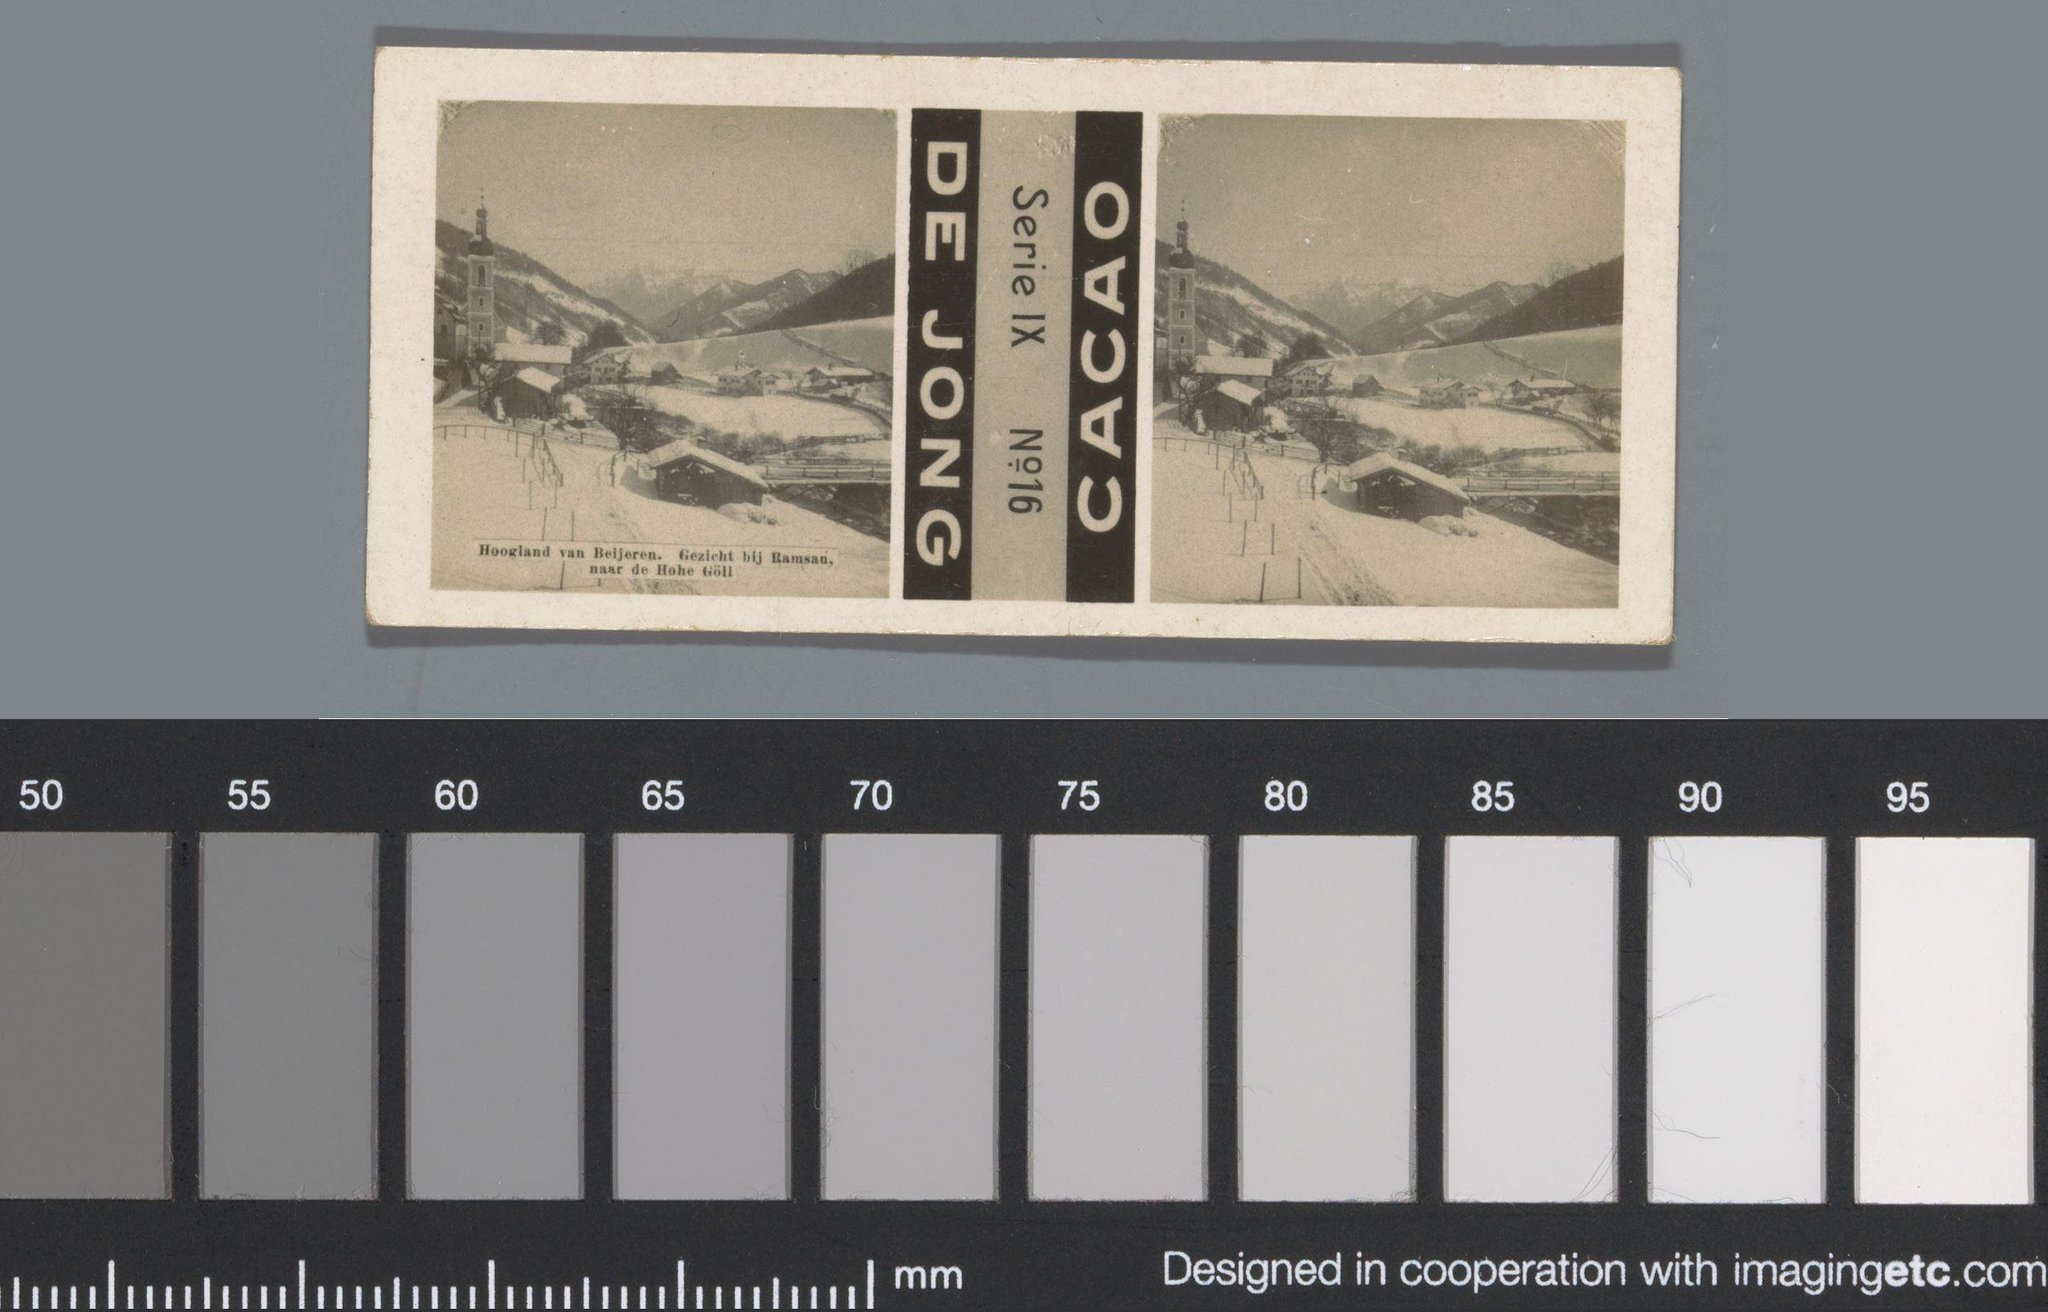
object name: stereograph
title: Gezicht op Ramsau bei Berchtesgaden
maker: Anonymous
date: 1900-1910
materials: cardboard, photographic support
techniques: gelatin silver print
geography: wormerveer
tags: city-view in general; 'veduta', mountain-range, snow peaks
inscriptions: number: ‘Serie IX No. 16’, inscription: ‘De Jong Cacao’